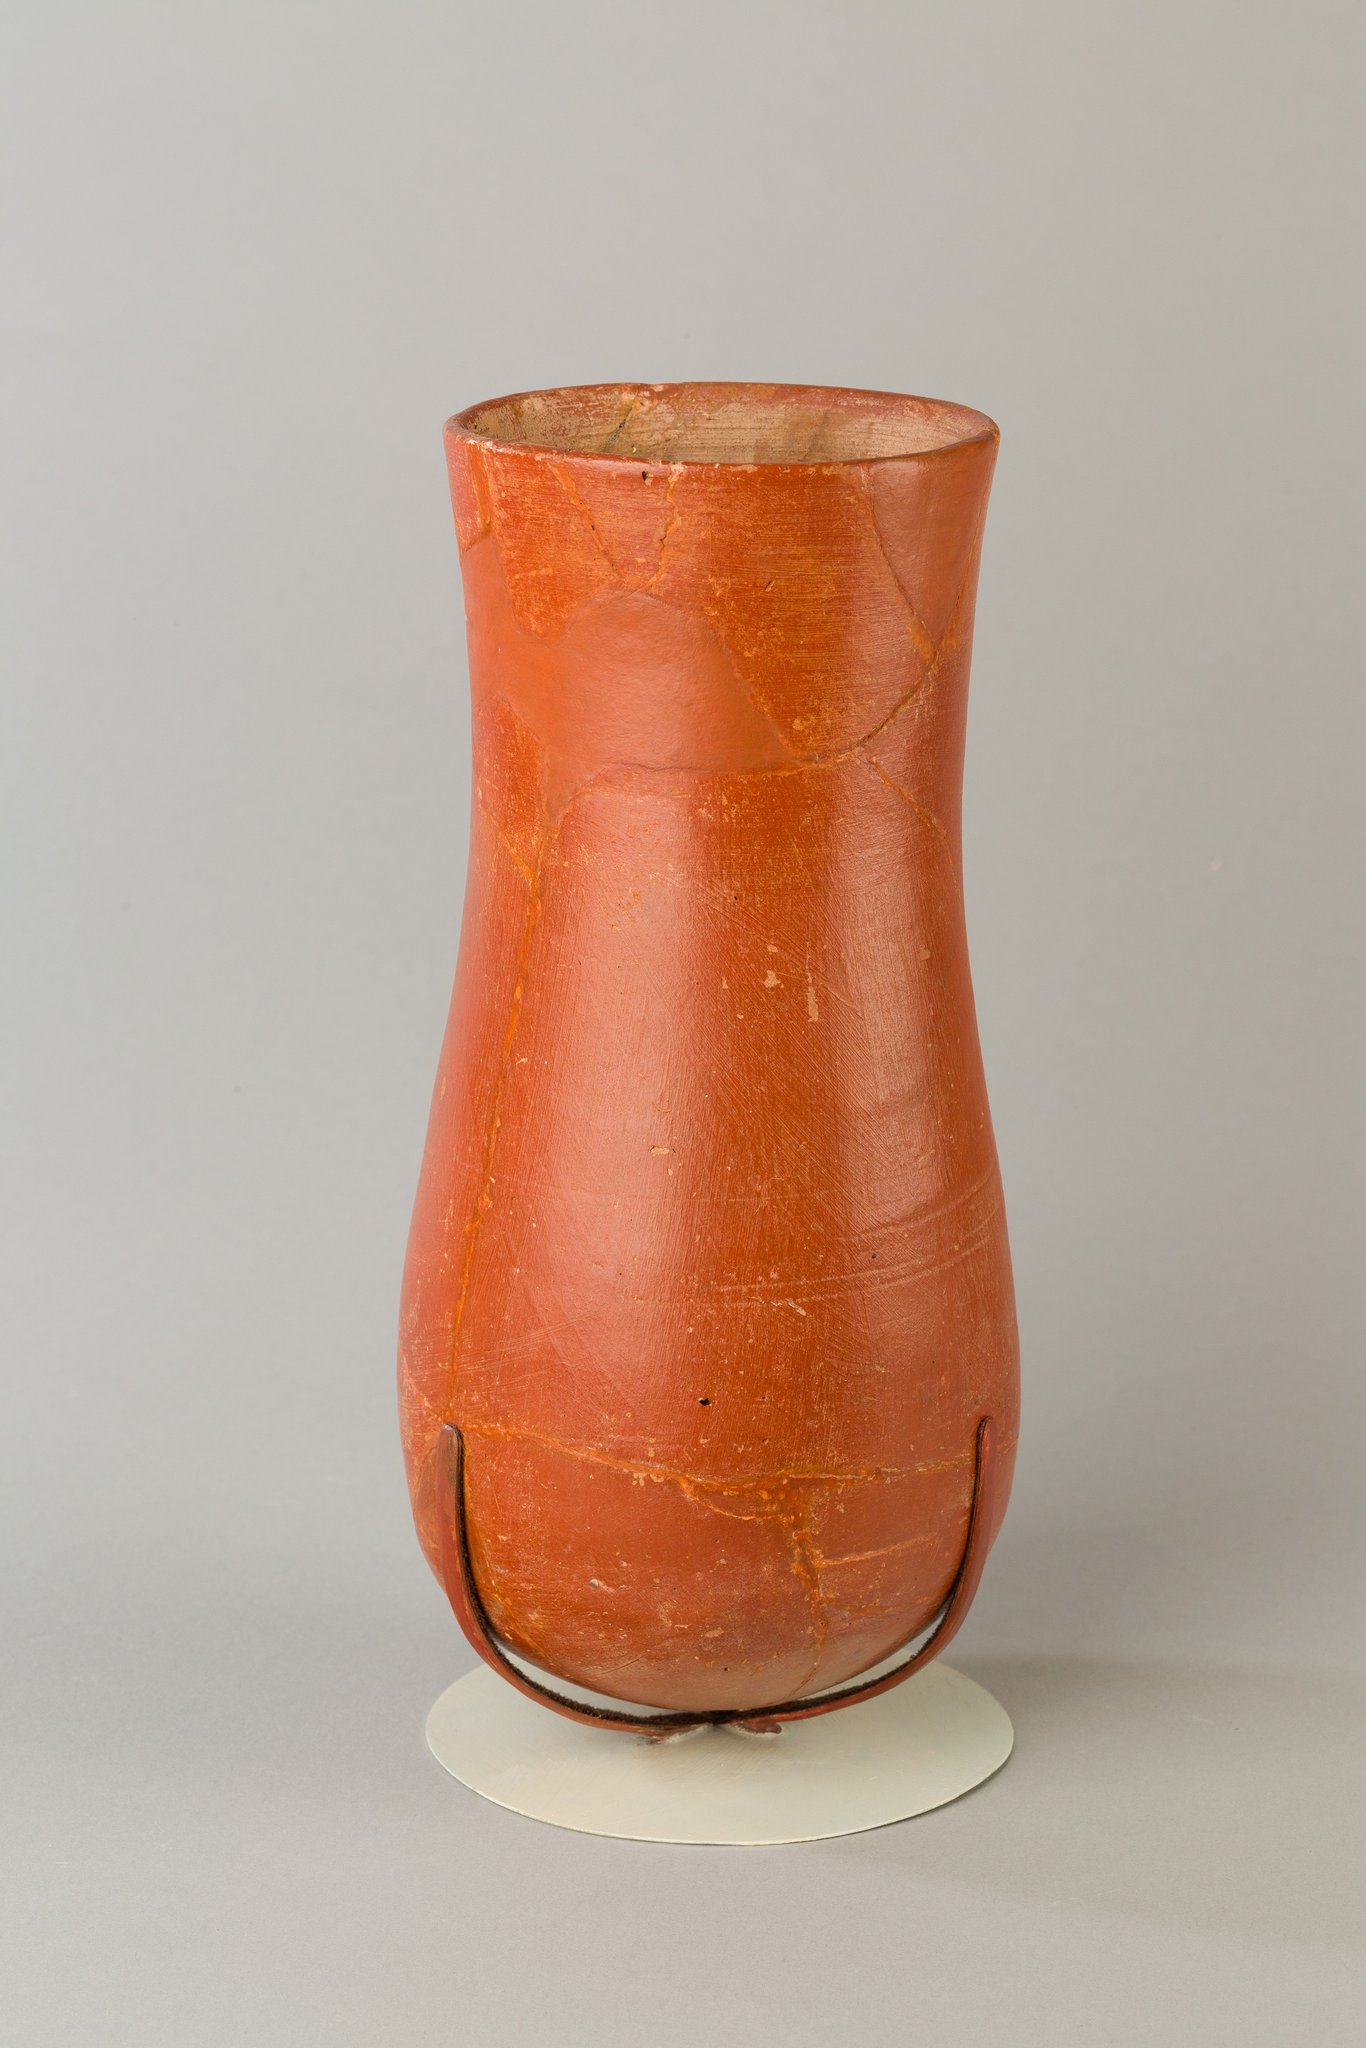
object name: cup, open mouthed, red ware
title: Cup from Tutankhamun's Embalming Cache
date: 1336-1327 BCE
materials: mineral, pottery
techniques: burnishing, wash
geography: egypt